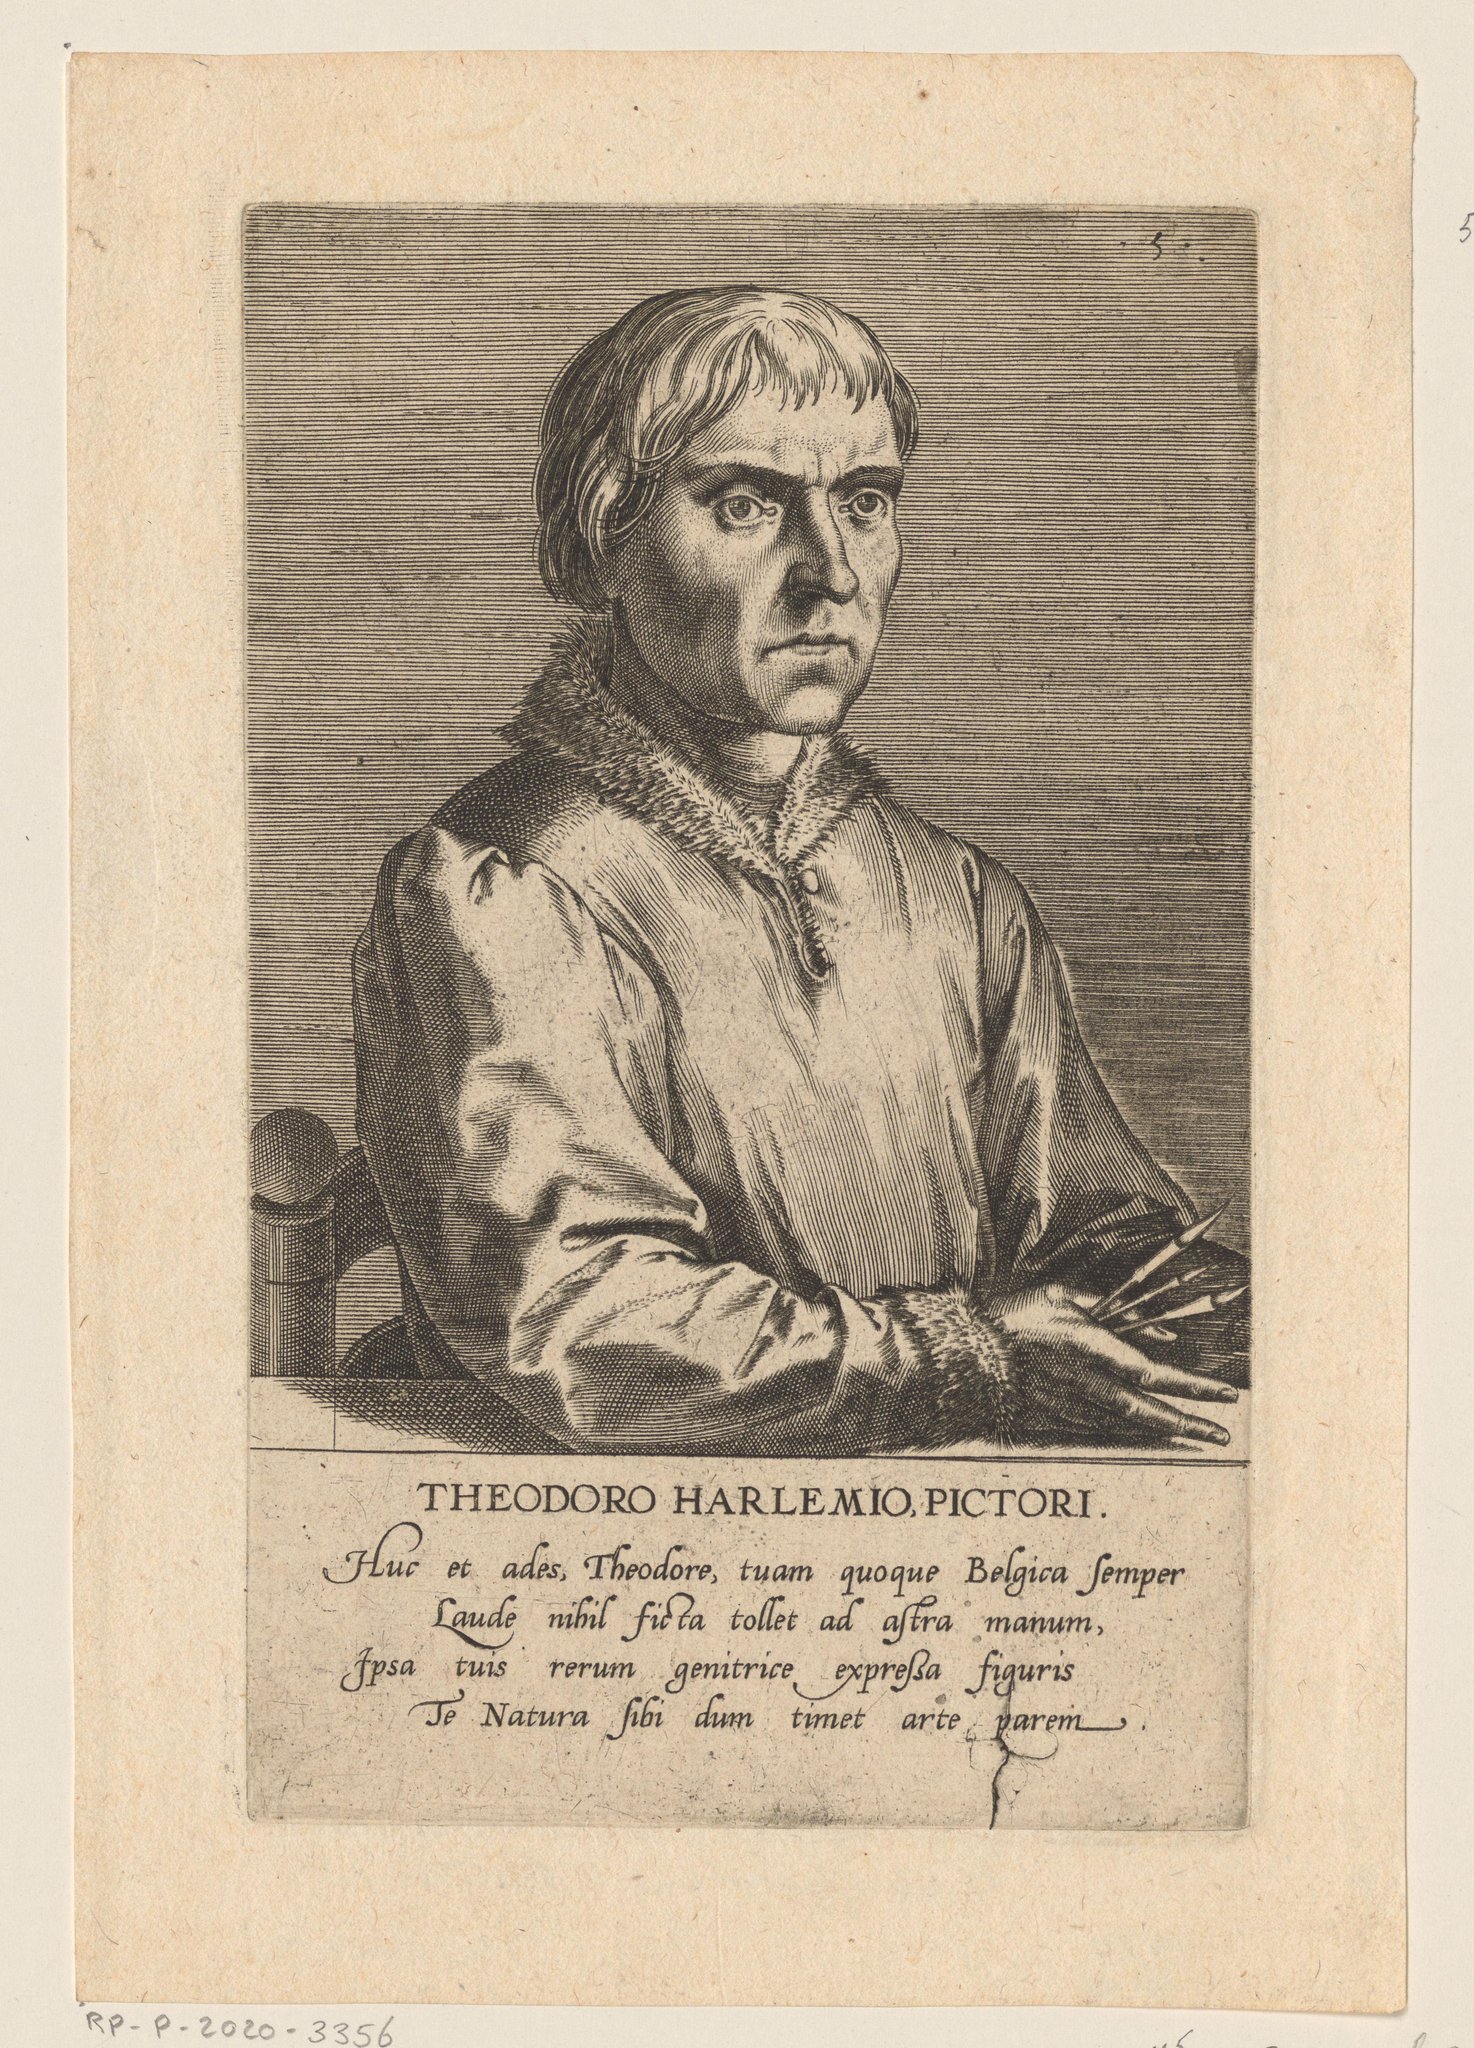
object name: print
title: Pictorum aliquot celebrium Germaniae Inferioris effigies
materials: paper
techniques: engraving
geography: antwerp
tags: haarlem, louvain, draughtsman, dieric bouts, historical persons, portrait, self-portrait of artist